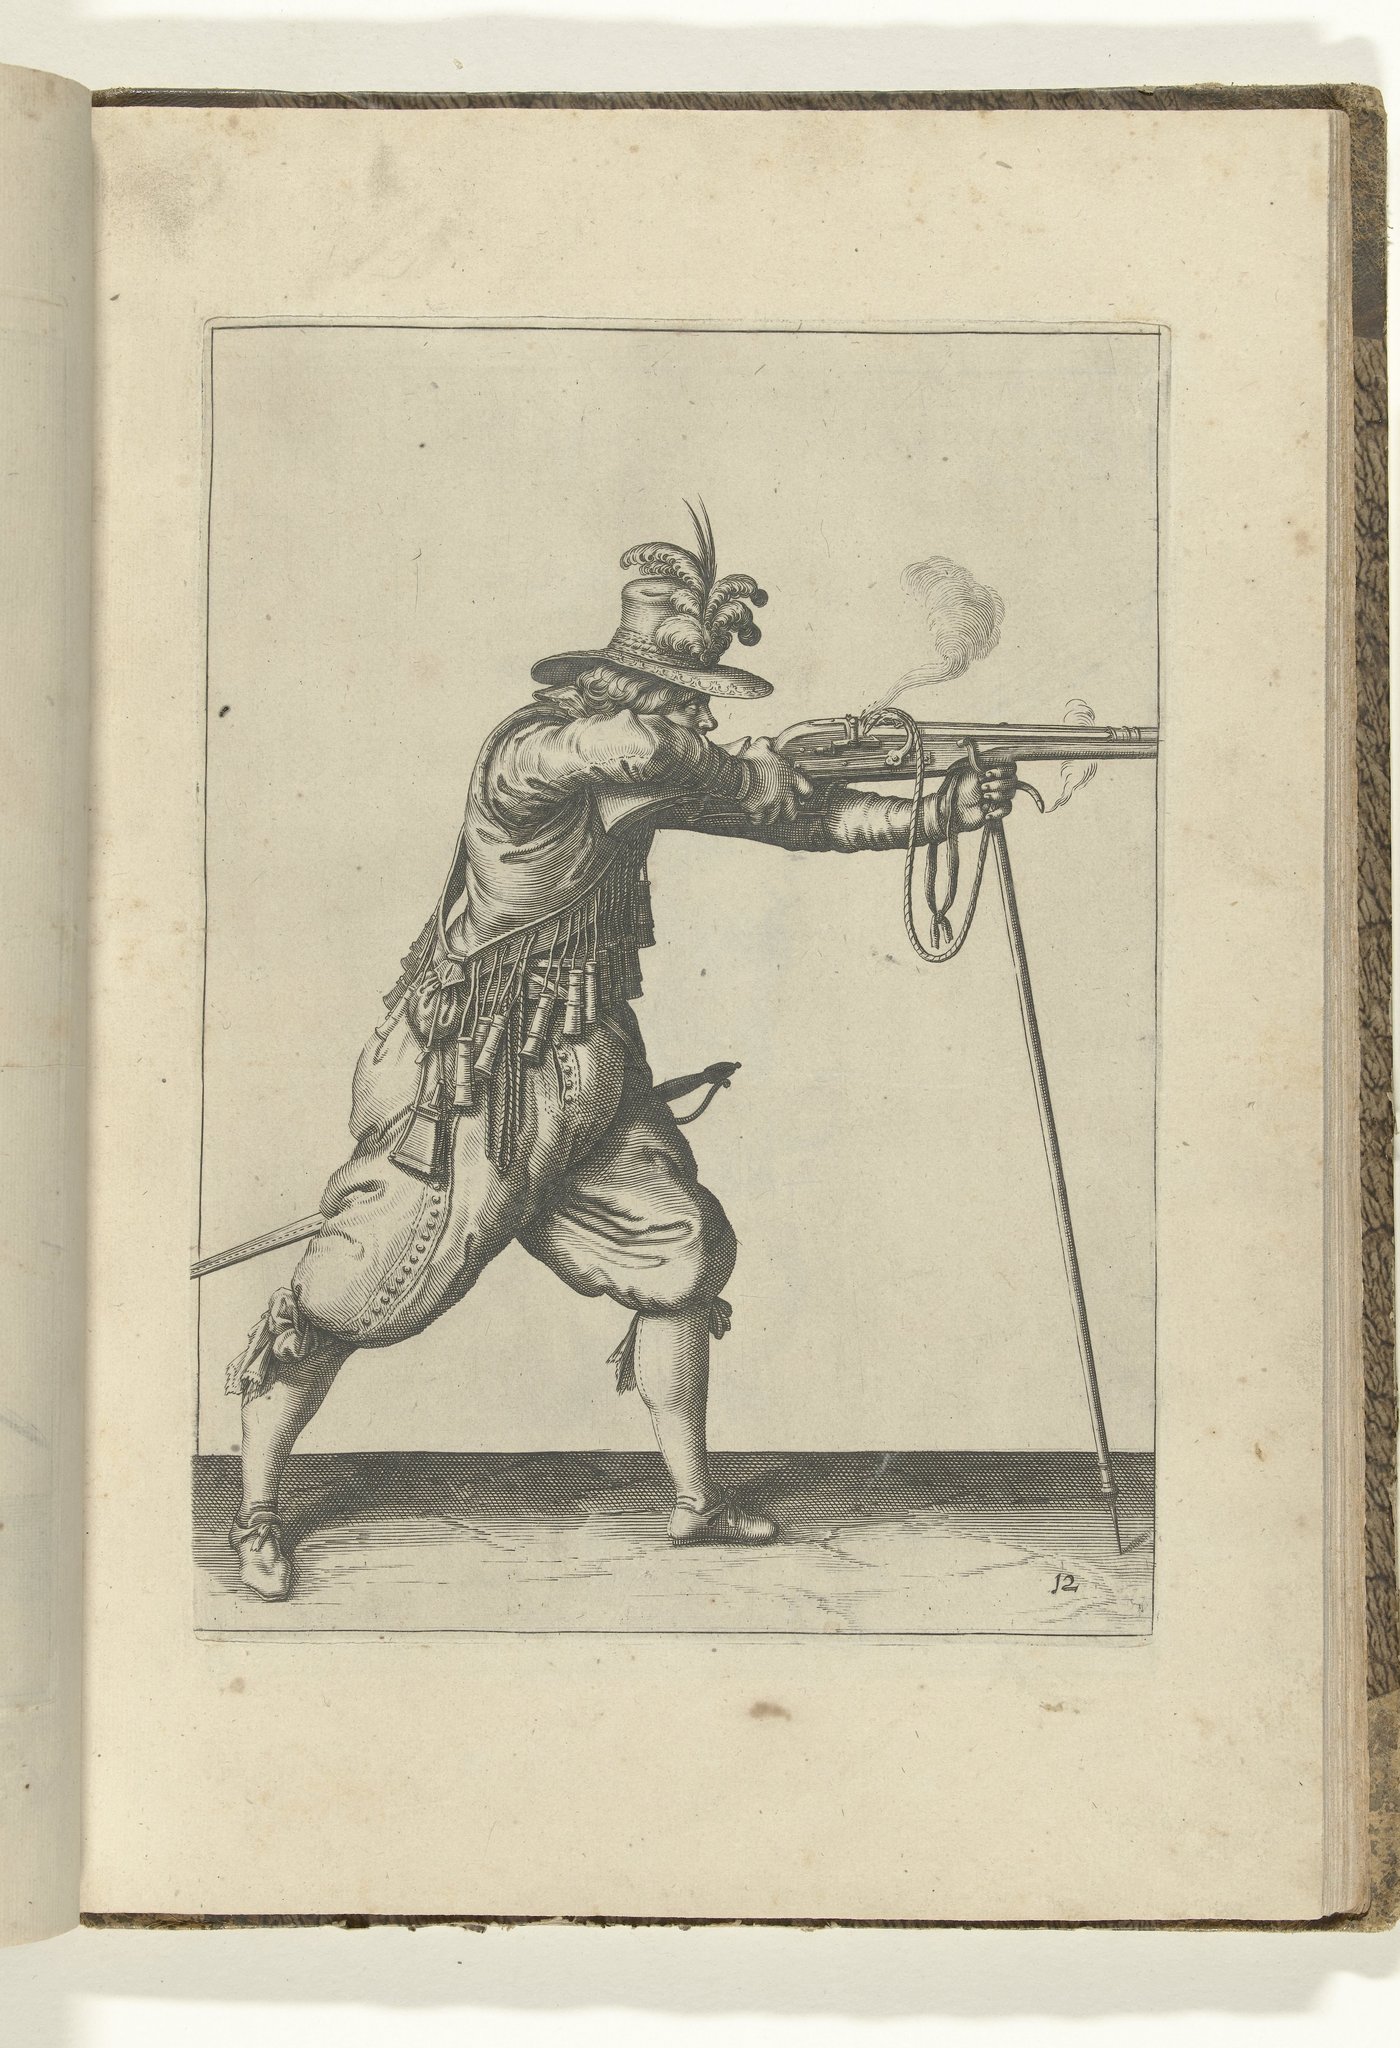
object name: print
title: Soldaat die zijn musket, steunend op zijn furket, afvuurt (nr. 12), ca. 1600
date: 1597-1608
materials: chalk, paper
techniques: engraving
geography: amsterdam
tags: the hague, maurice (prince of orange), handling of weapons ~ military training, weapons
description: Een soldaat, ten voeten uit, naar rechts, die een musket (een bepaald type vuurwapen) met beide handen richt op een doelwit, de loop steunend op een furket (musketvork), en afvuurt (nr. 12), ca. 1600. Plaat 12 in de instructies voor het hanteren van het musket: Brief enseignement, sur les pourtraitz figurez, touchant le droit maniement du Mousquet. Onderdeel van de illustraties in een Franse editie van J. de Gheyns Wapenhandelinghe: J. de Gheyn, Maniement d'armes, d'arquebuses, mousquetz et piques : en conformité de l'ordre de Mour le Prince Maurice, Prince d'Orange, Amsterdam 1608. Krijgswezen rond 1600.